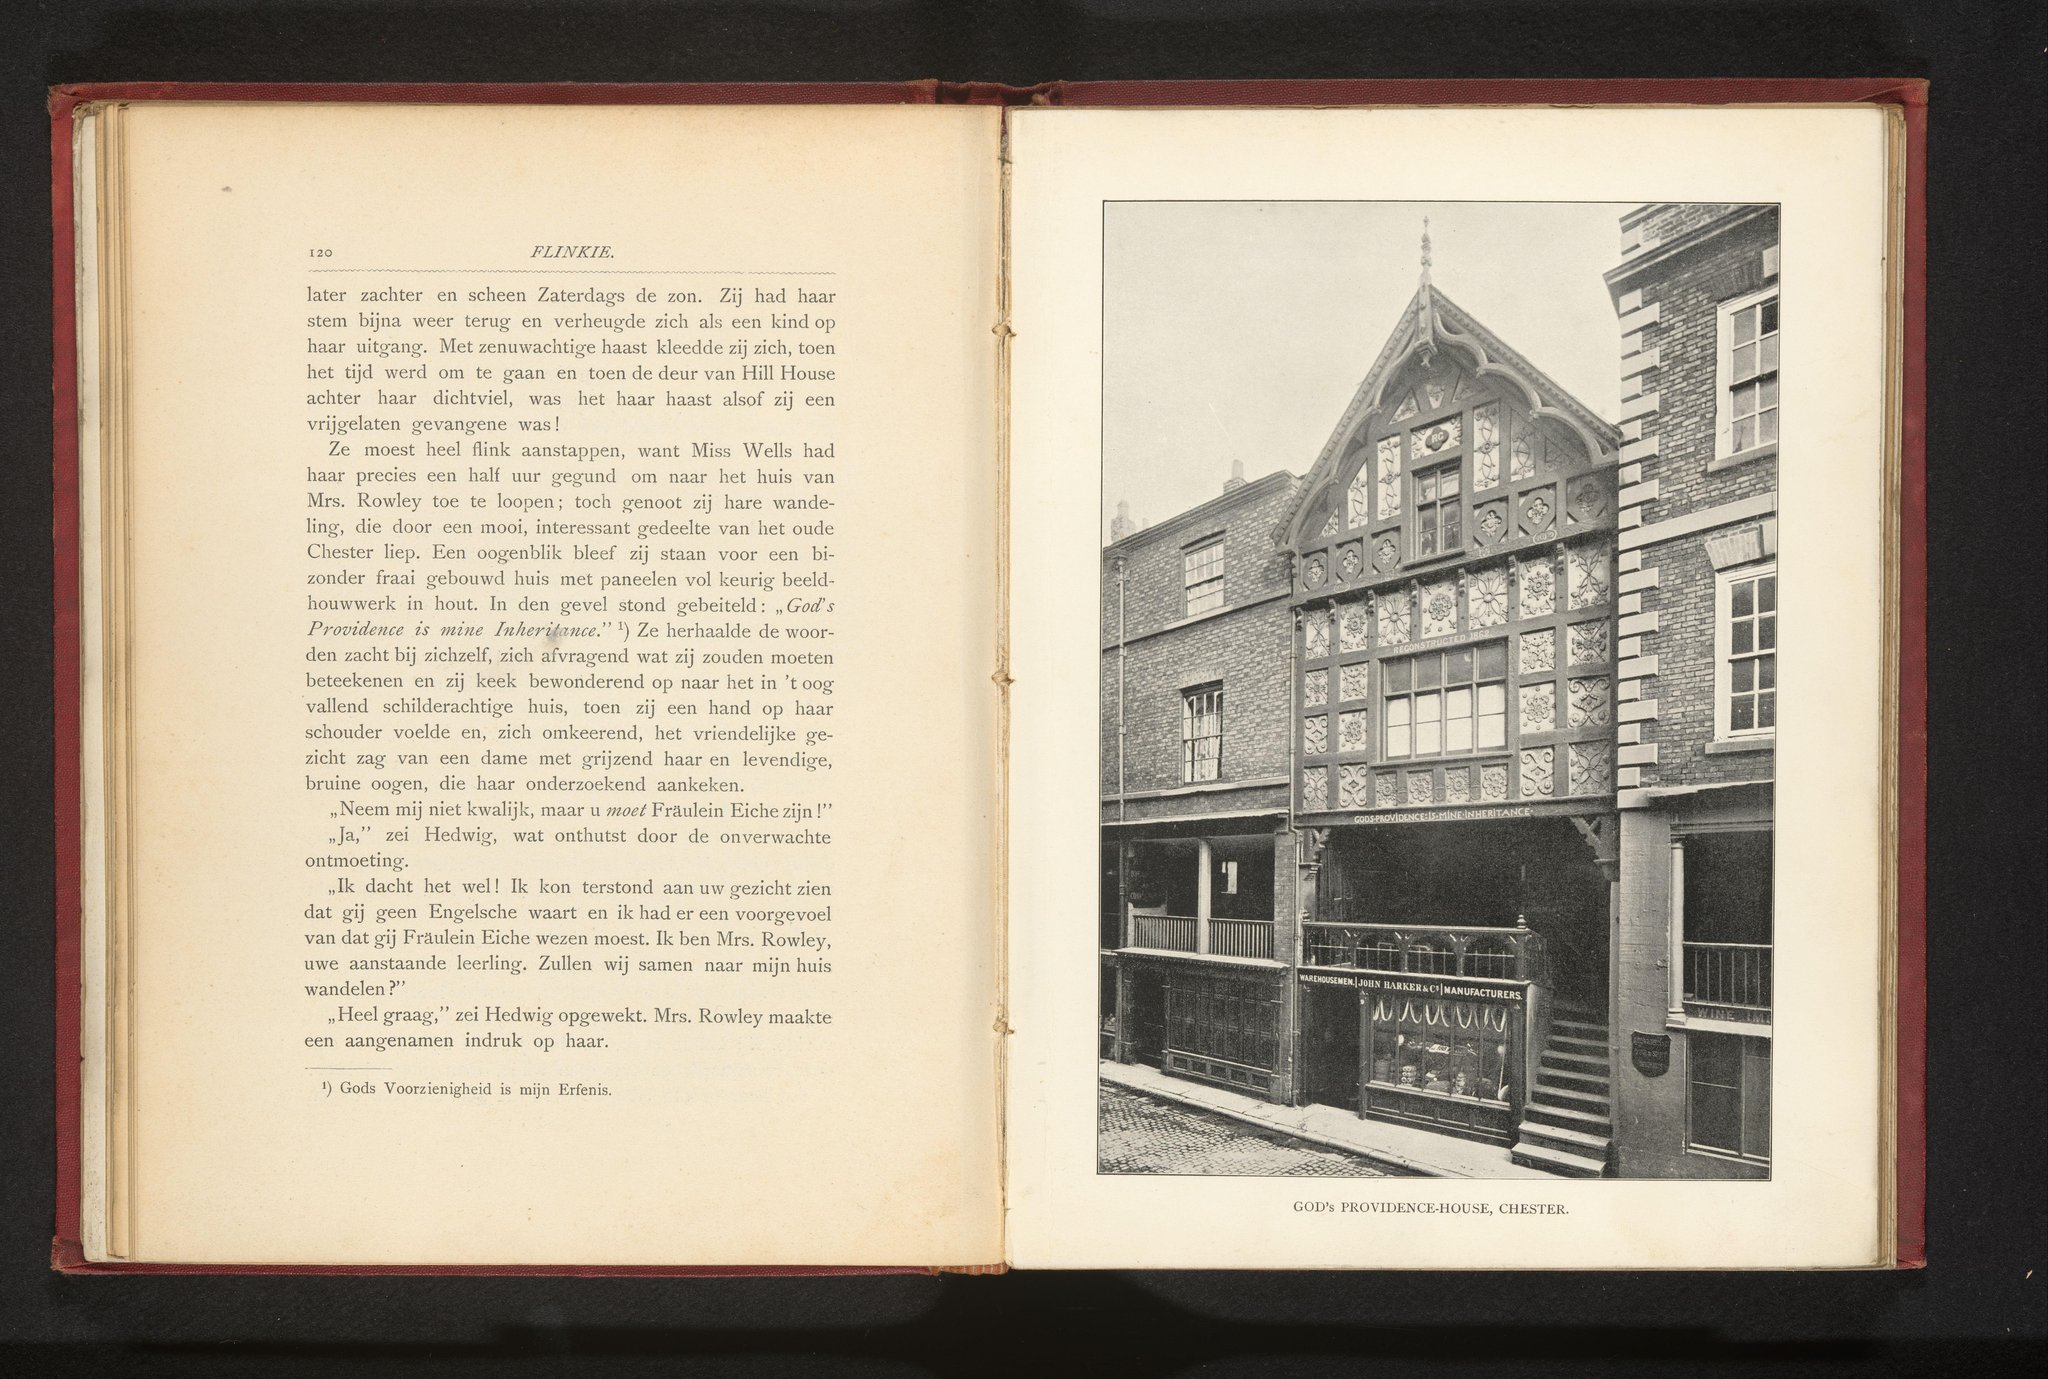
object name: photomechanical print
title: God's Providence-House, Chester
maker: Anonymous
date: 1901-1906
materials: paper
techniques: autotype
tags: the usual house or row of houses